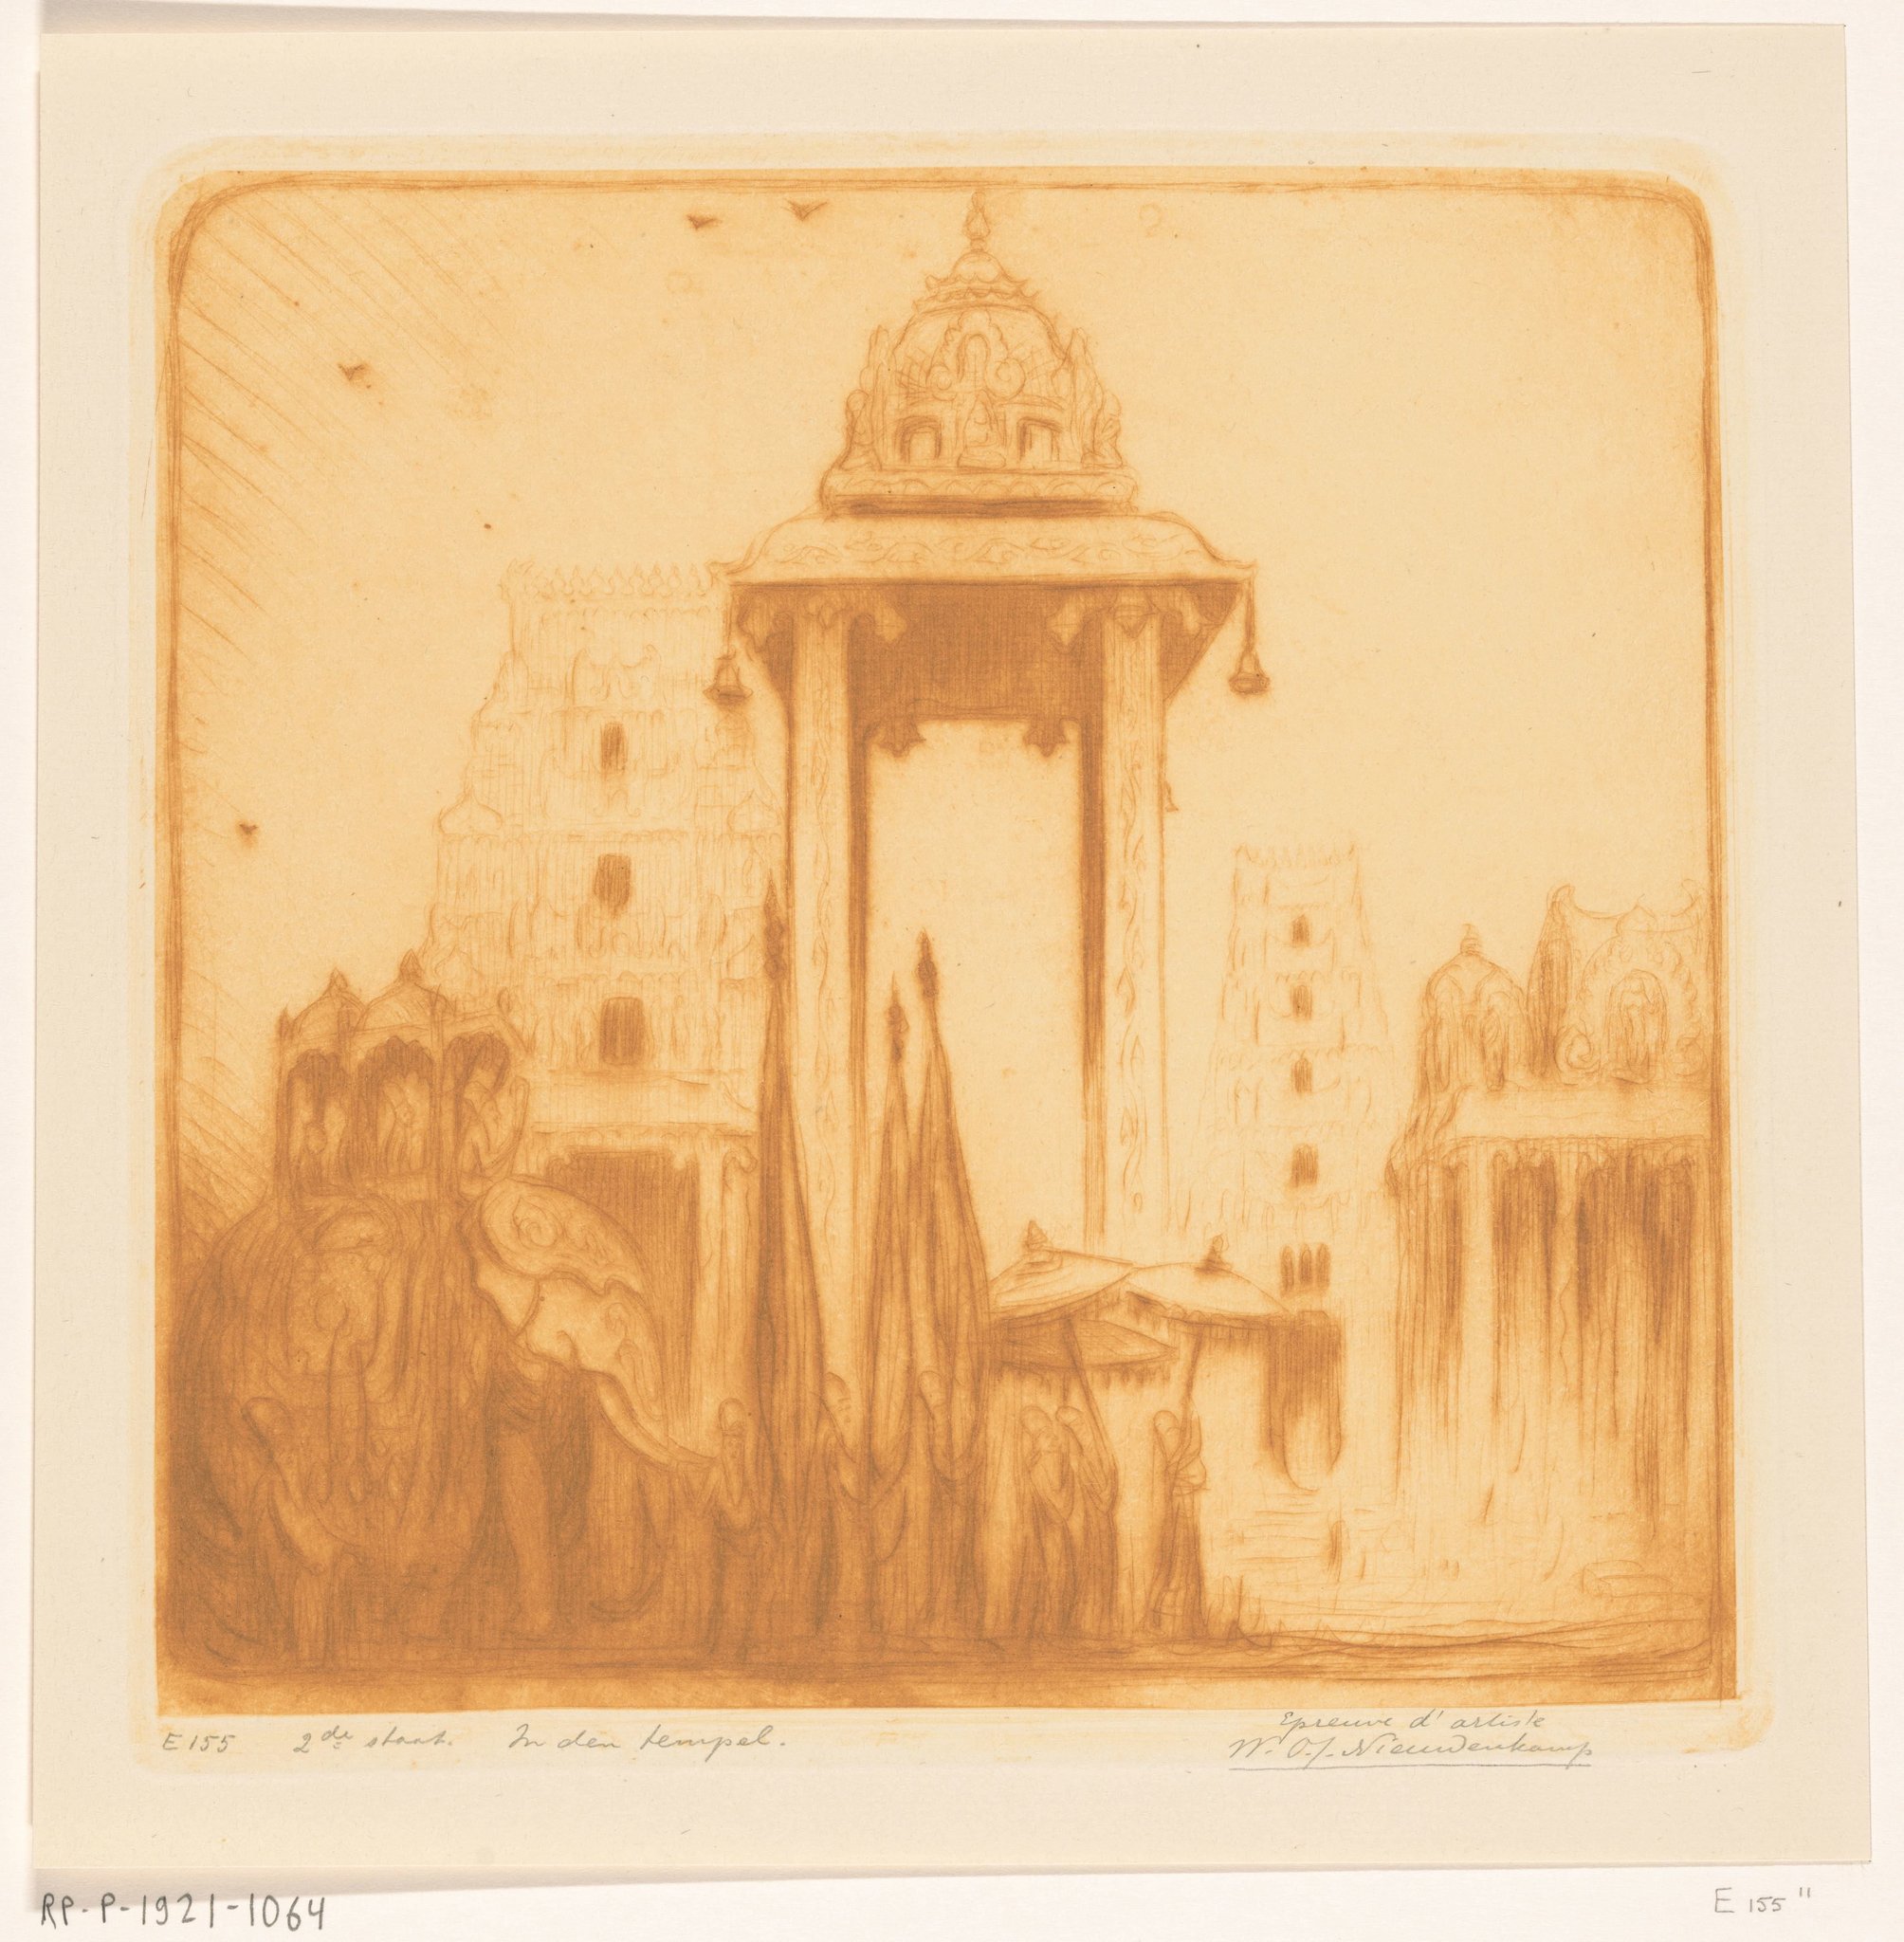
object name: print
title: In den tempel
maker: wijnand otto jan nieuwenkamp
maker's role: draughtsman, print maker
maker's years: 1874-1950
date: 1914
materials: paper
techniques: drypoint, intaglio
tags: temple, shrine ~ hinduism, buddhism, jainism, riding on animal other than horse, ass, or mule, courtyard, trunked animals: elephant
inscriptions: collector's mark: Lugt 2233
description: Links op de voorgrond een olifant die achter figuren met vaandels en zonneschermen loopt.